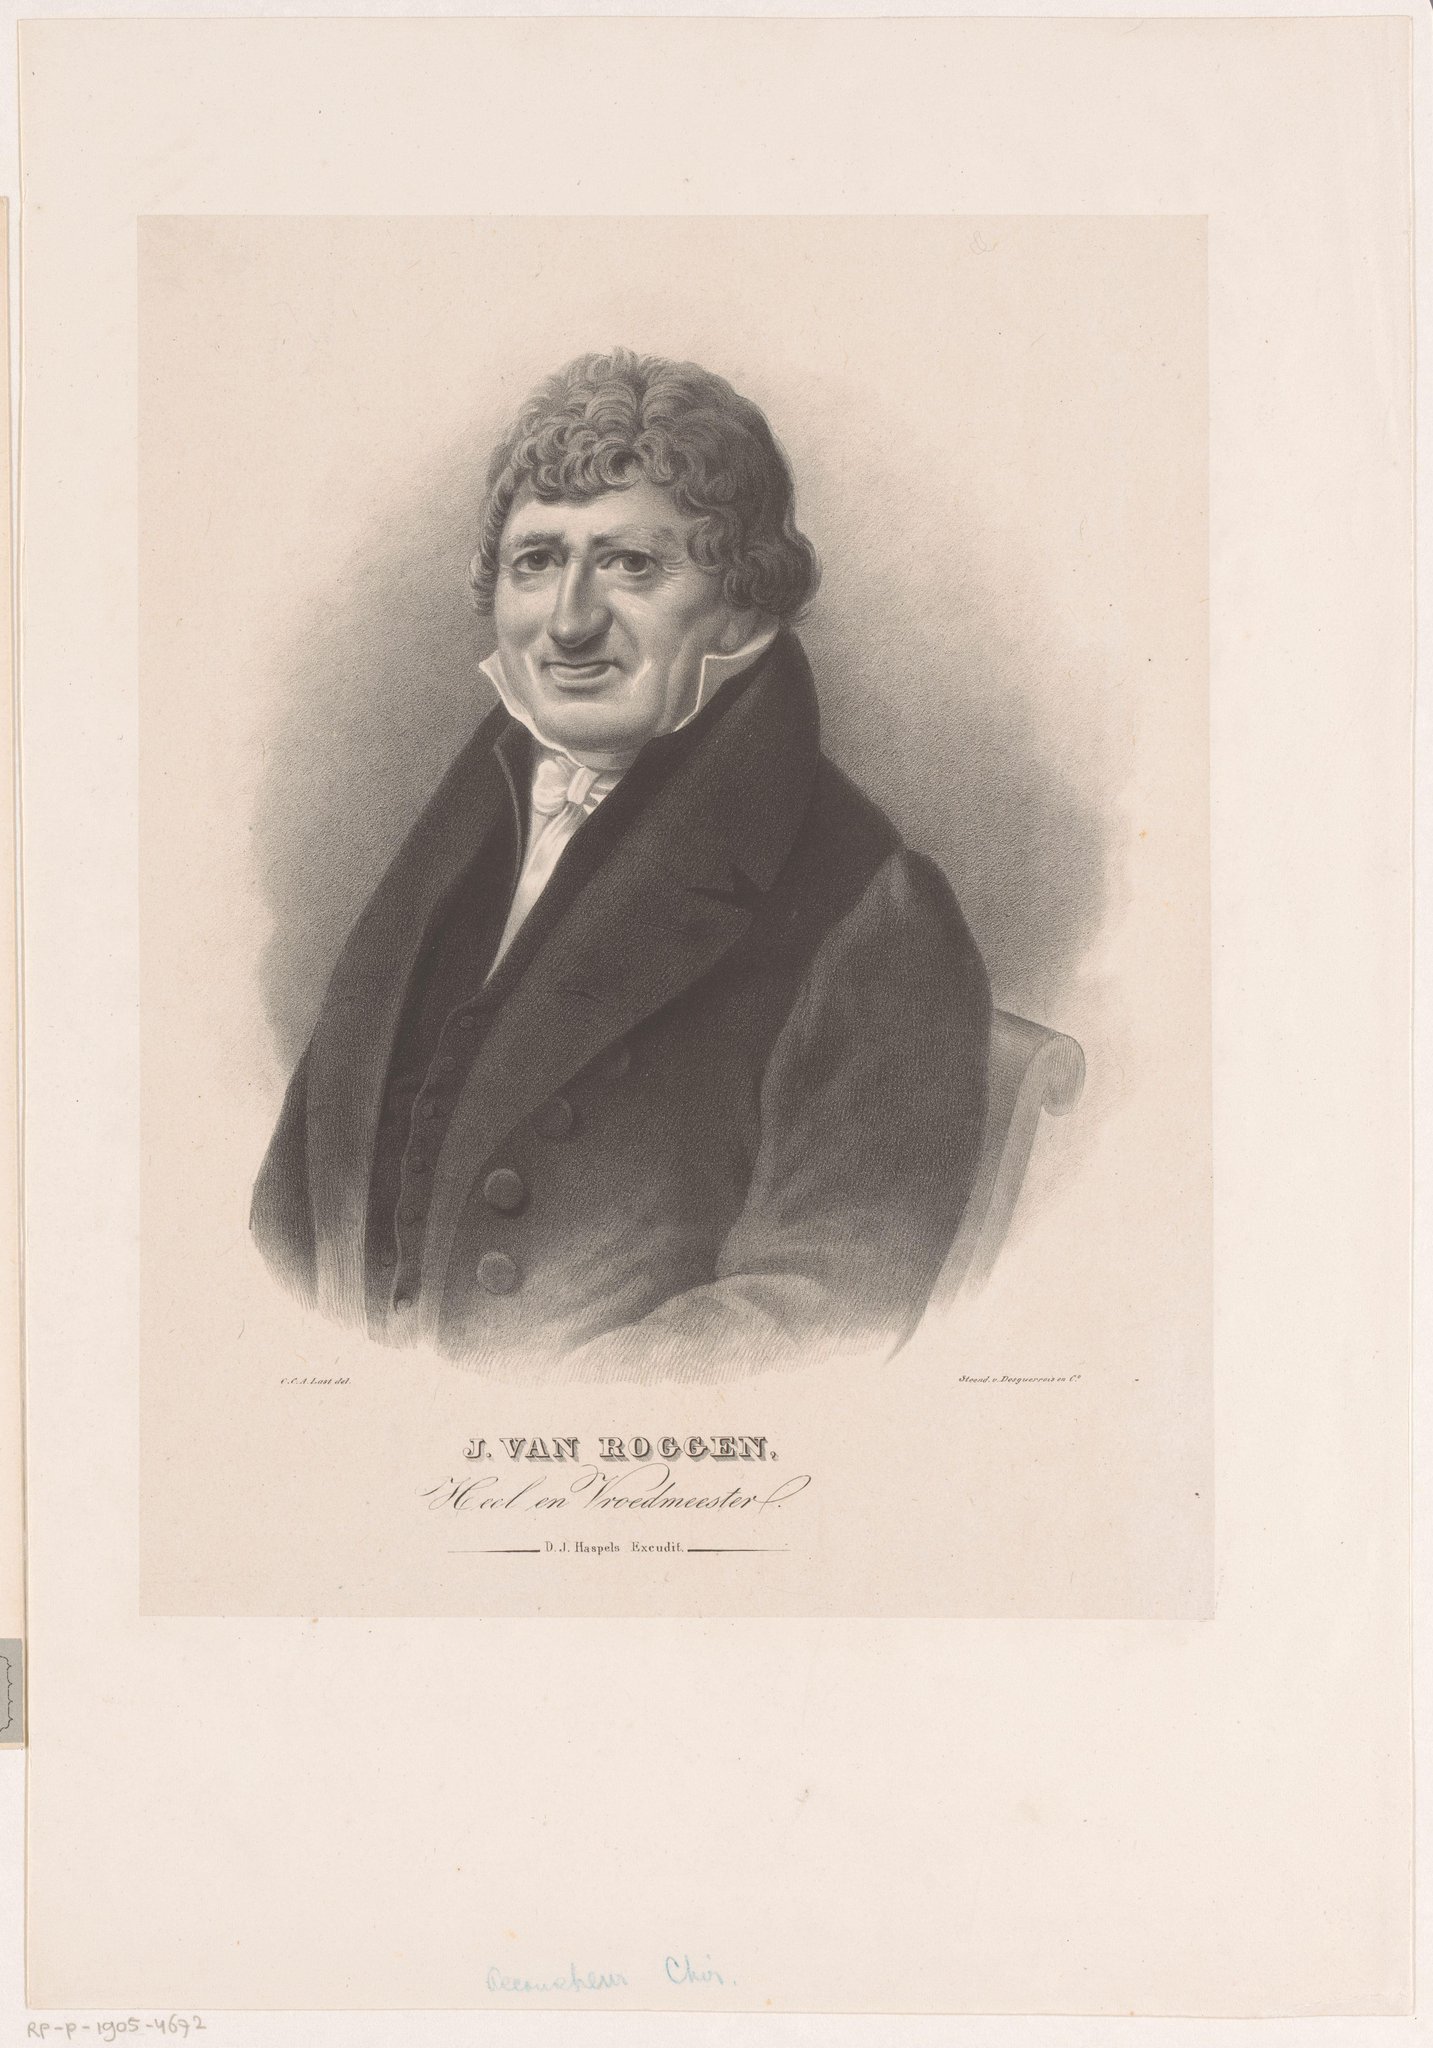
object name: print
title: J. van Roggen, heel en vroedmeester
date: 1827-1839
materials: paper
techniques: lithograph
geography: amsterdam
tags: historical persons (+ (full) bust portrait)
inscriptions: collector's mark: Lugt 2228